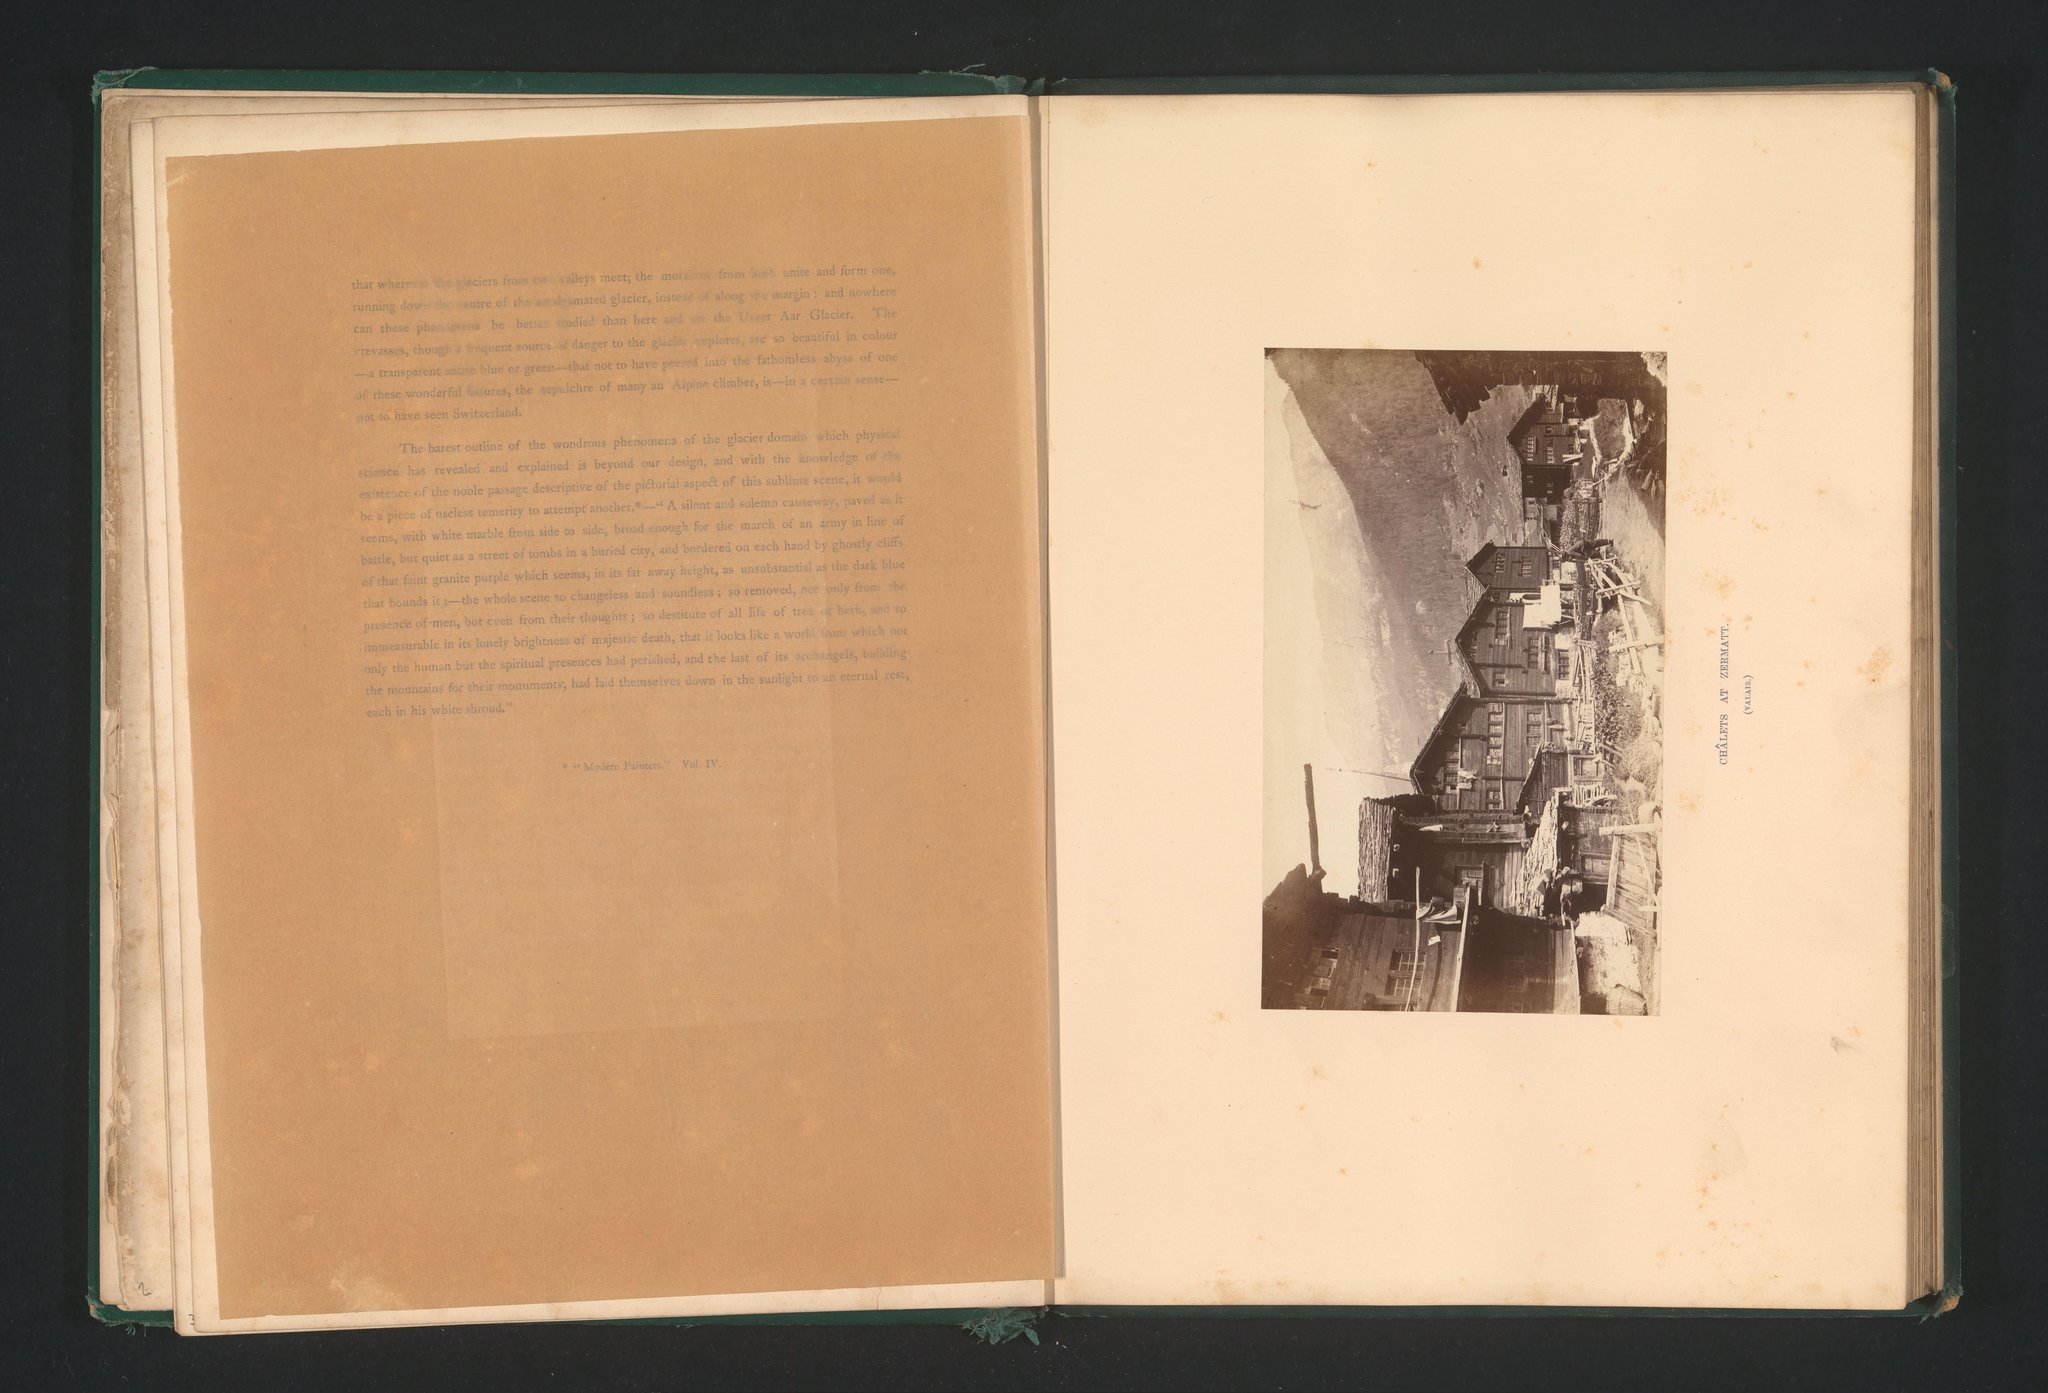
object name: photograph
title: Gezicht op chalets in Zermatt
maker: stephen thompson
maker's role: fotograaf, schrijver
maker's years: 1831-1893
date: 1863-1868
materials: photographic support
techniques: albumen print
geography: zermatt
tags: hut, cabin, lodge, street (+ city(-scape) with figures, staffage)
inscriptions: inscription: ‘(valais)’